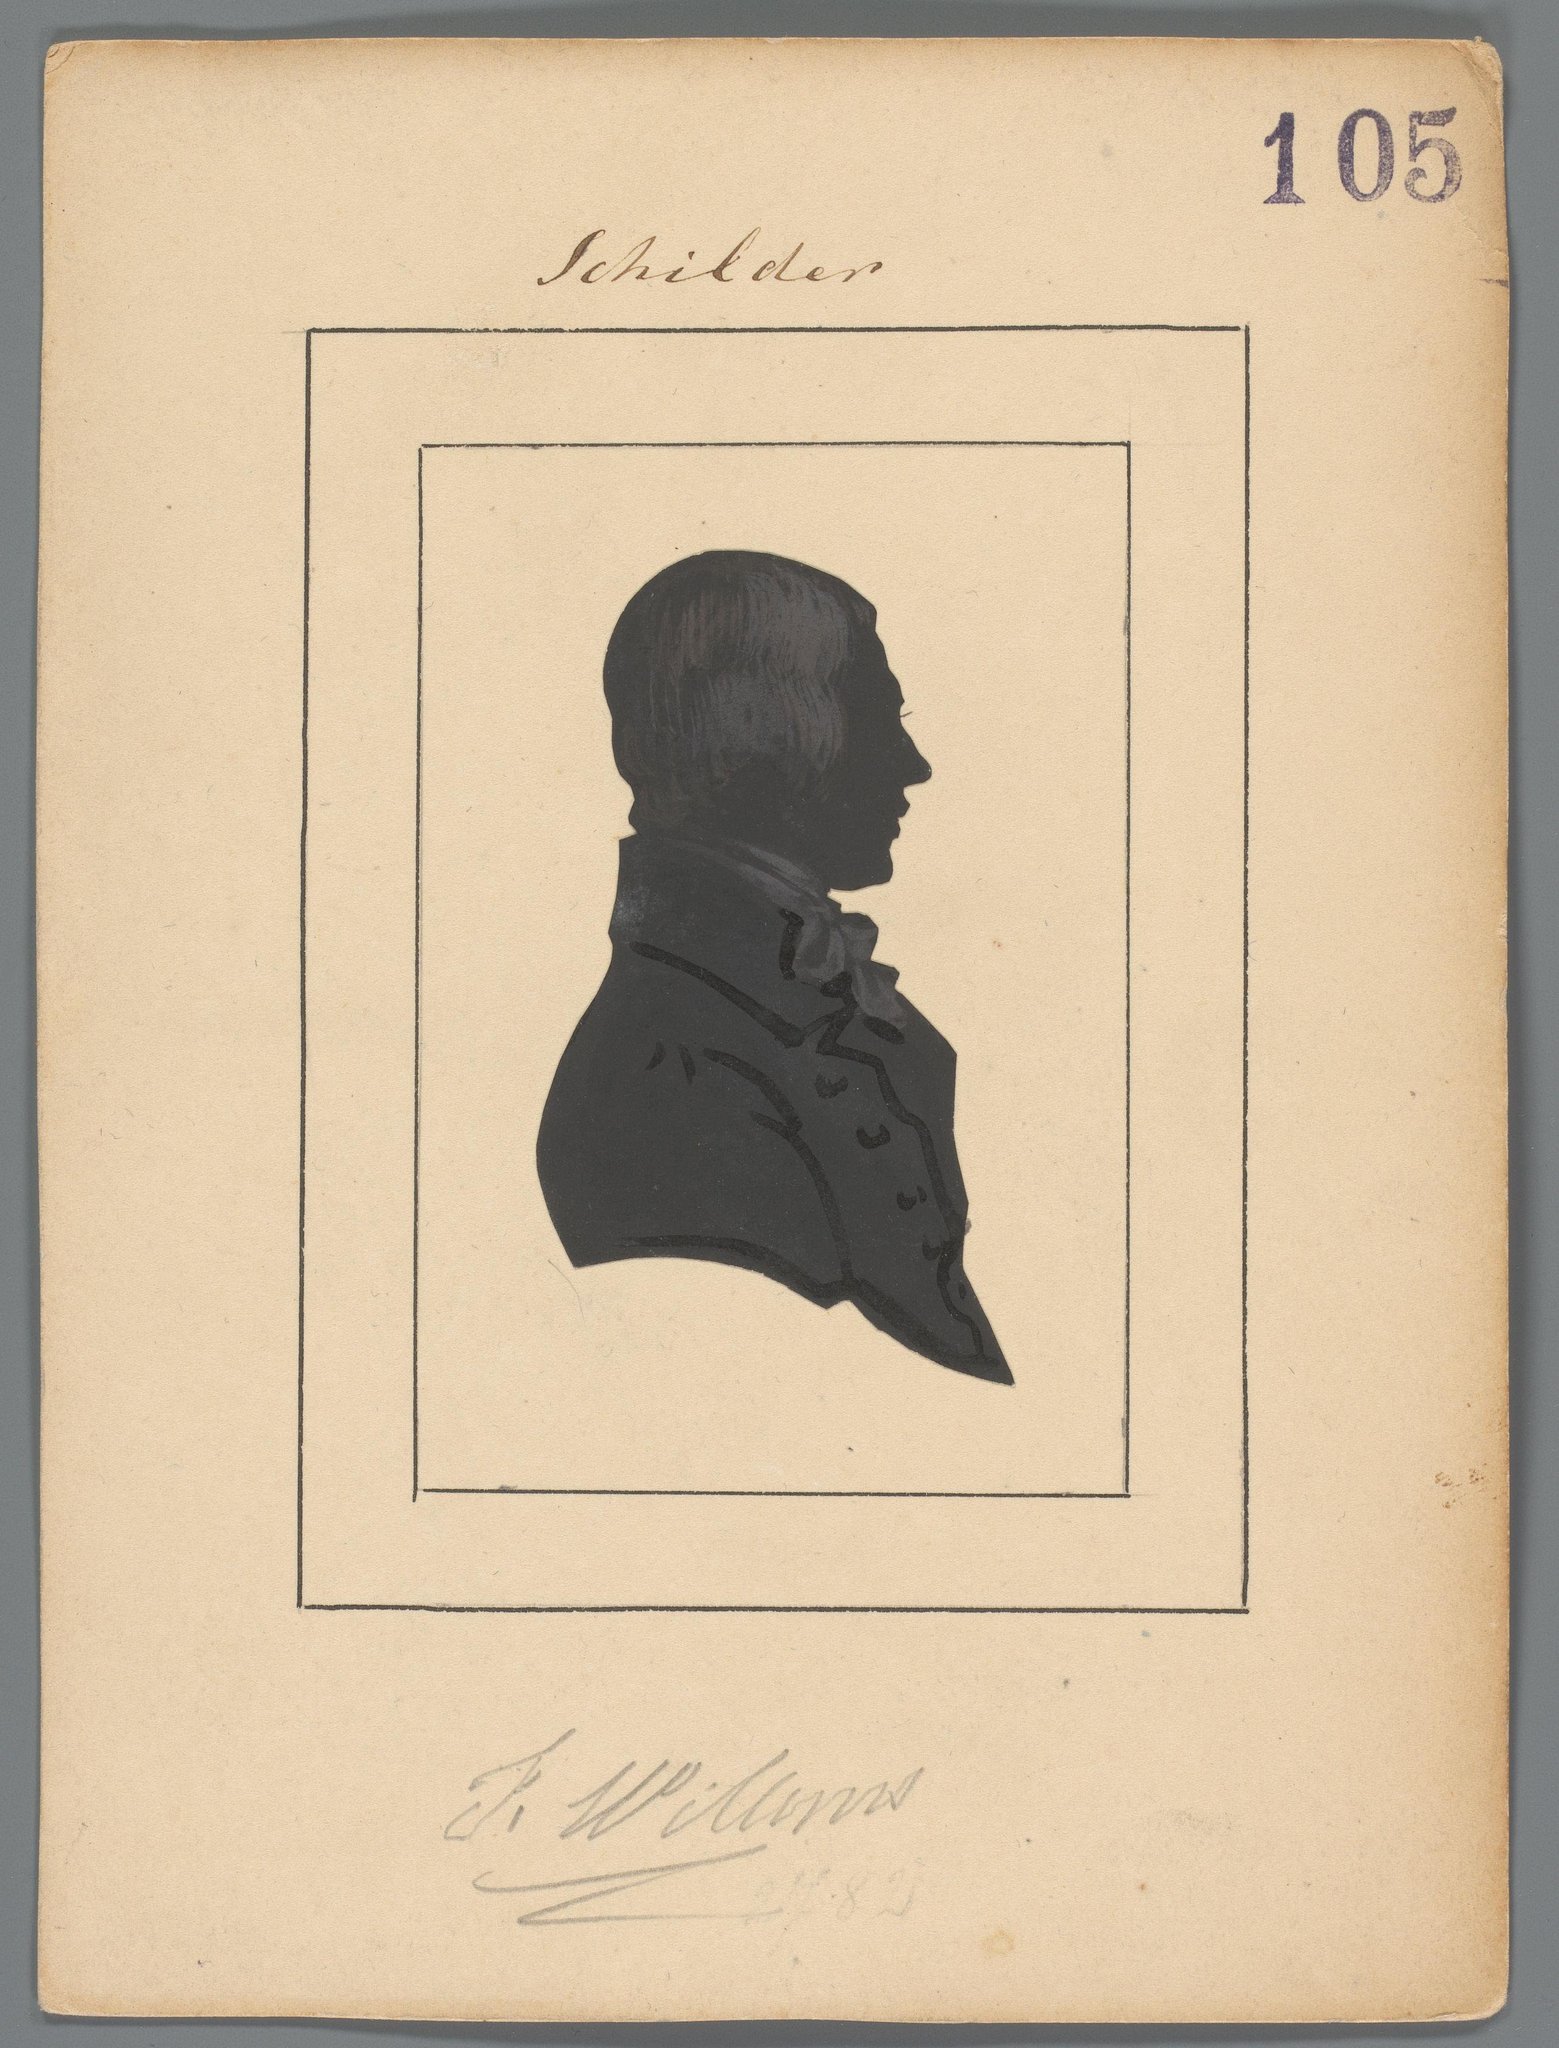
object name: cut paper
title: Silhouetportret van Florent Willems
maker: elisabeth alida haanen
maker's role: draughtsman, print maker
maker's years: 1809-1845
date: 1819-1845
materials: ink, paint, paper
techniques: brush, snipping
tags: liège, painter, florent willems, historical persons, portrait, self-portrait of painter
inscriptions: inscription: ‘F. Willems’, collector's mark: ‘Ex-libris van Beresteyn’, number: ‘105’, inscription: ‘Neg. D. 1740’, number: ‘13976’, inscription: ‘Schilder’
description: Met onder het portret de handtekening van de geportretteerde.